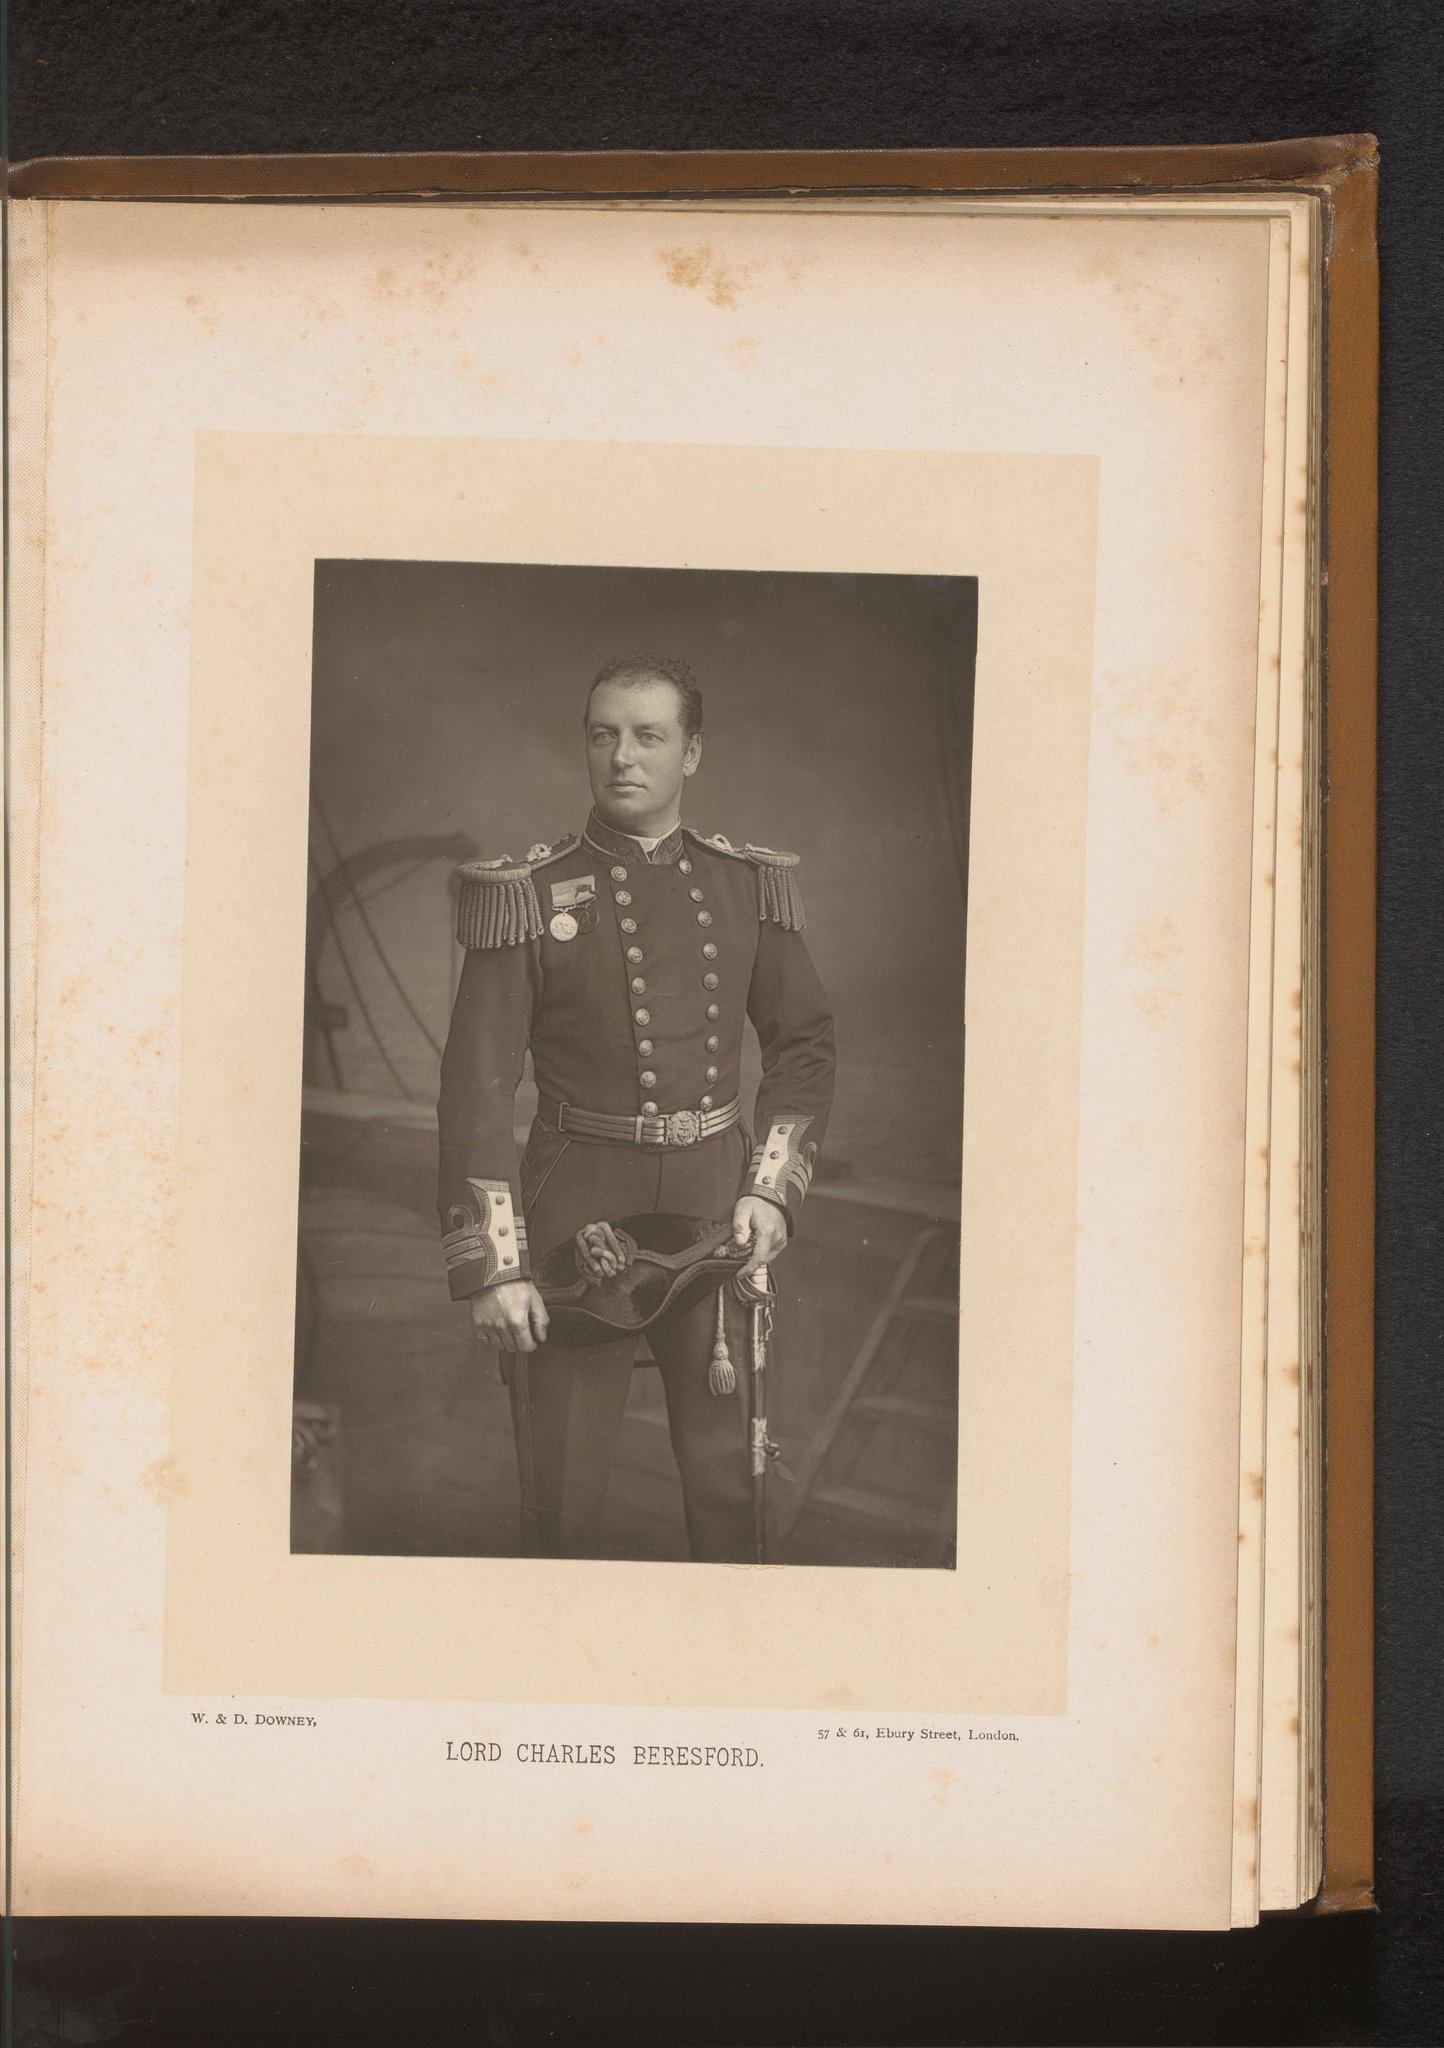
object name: page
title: Portret van Charles Beresford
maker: Anonymous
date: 1880-1890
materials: paper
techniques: woodburytype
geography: london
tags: commander-in-chief, admiral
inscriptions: inscription: ‘57 & 61, Elbury Street, London.’